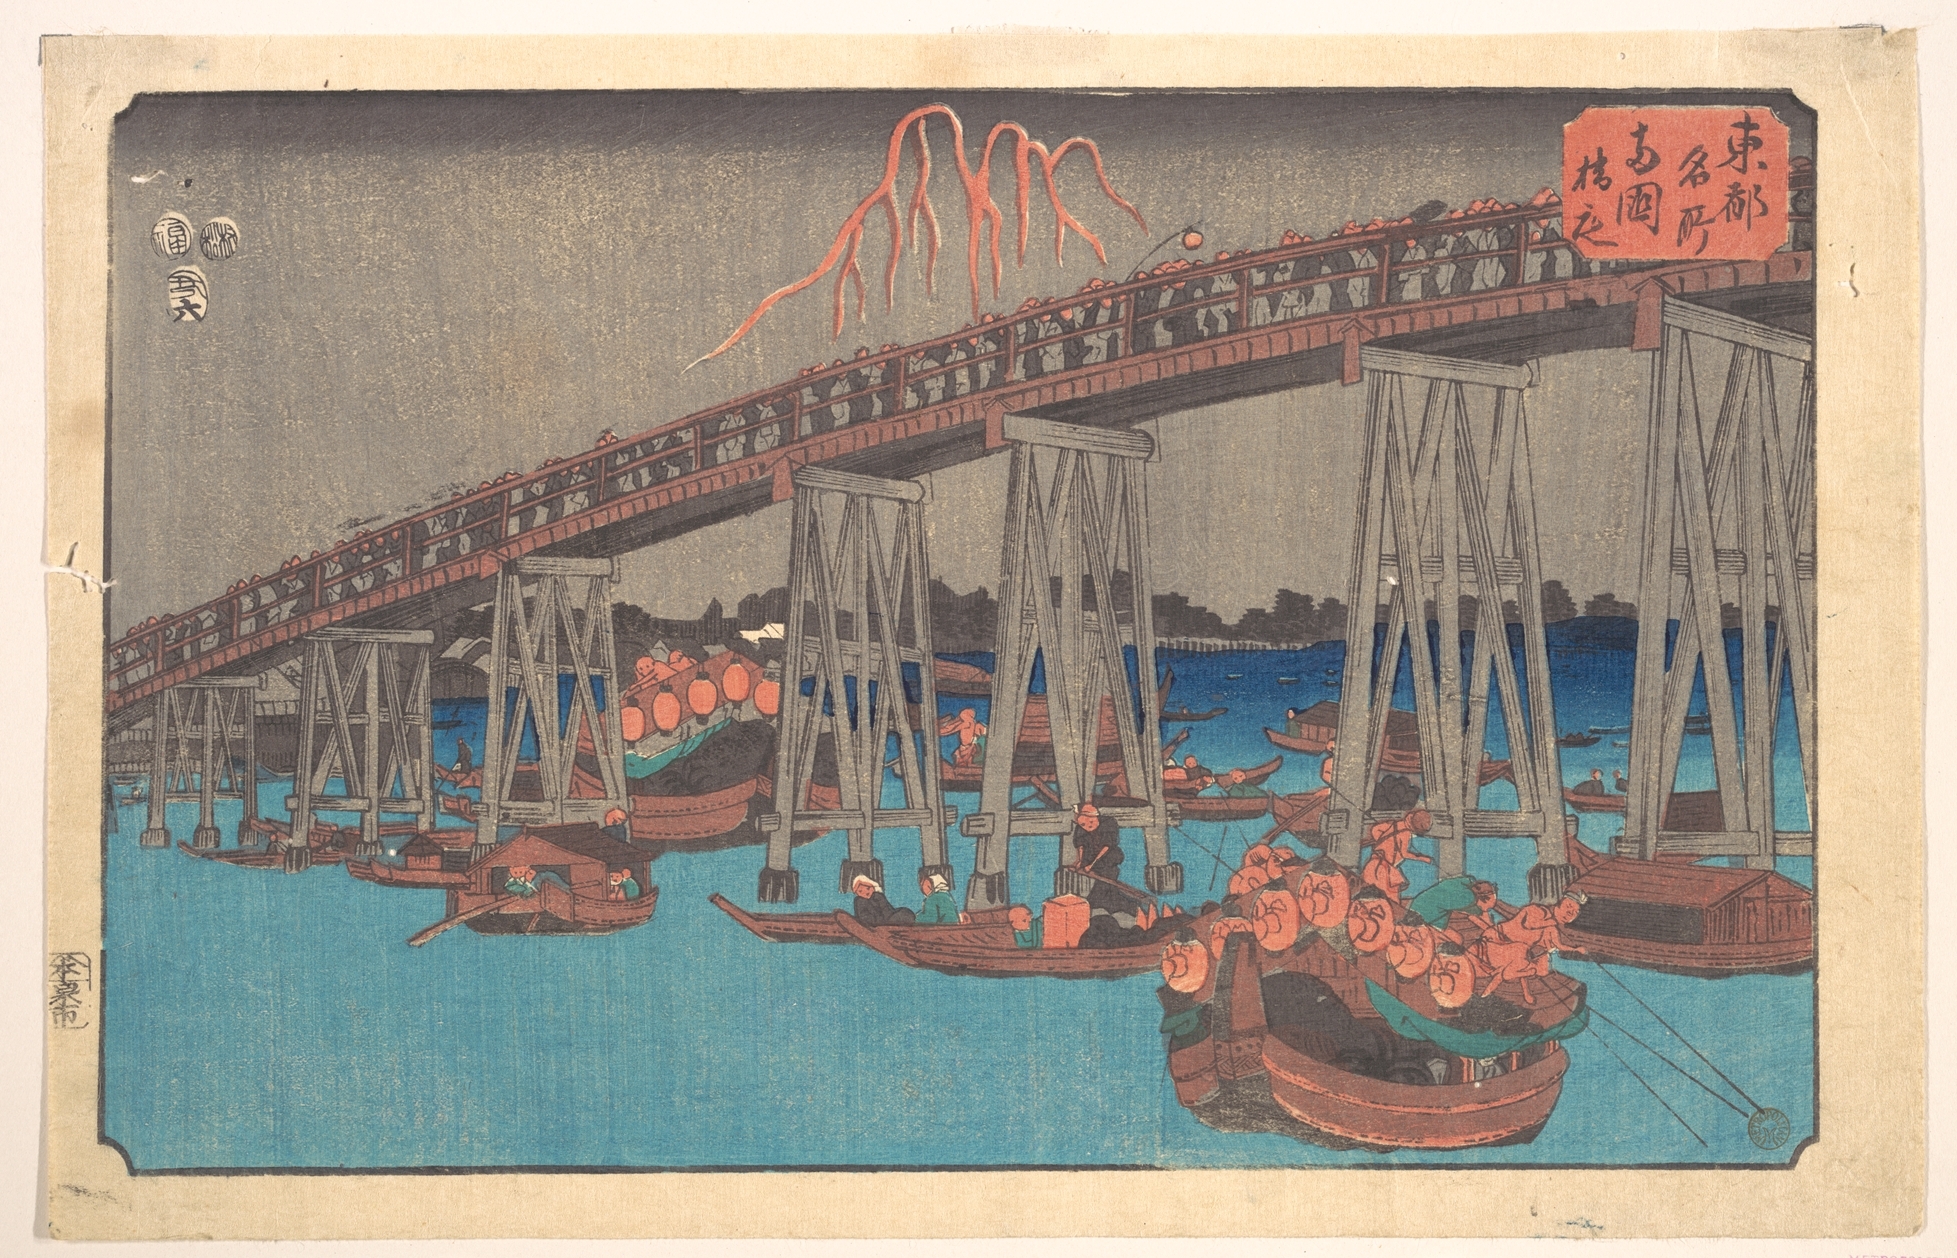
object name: print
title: Ryogoku Hanabi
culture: japanese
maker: utagawa hiroshige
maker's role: artist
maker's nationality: japanese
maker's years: 1797-1858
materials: ink, paper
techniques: woodblock print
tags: bridges,rivers,boats